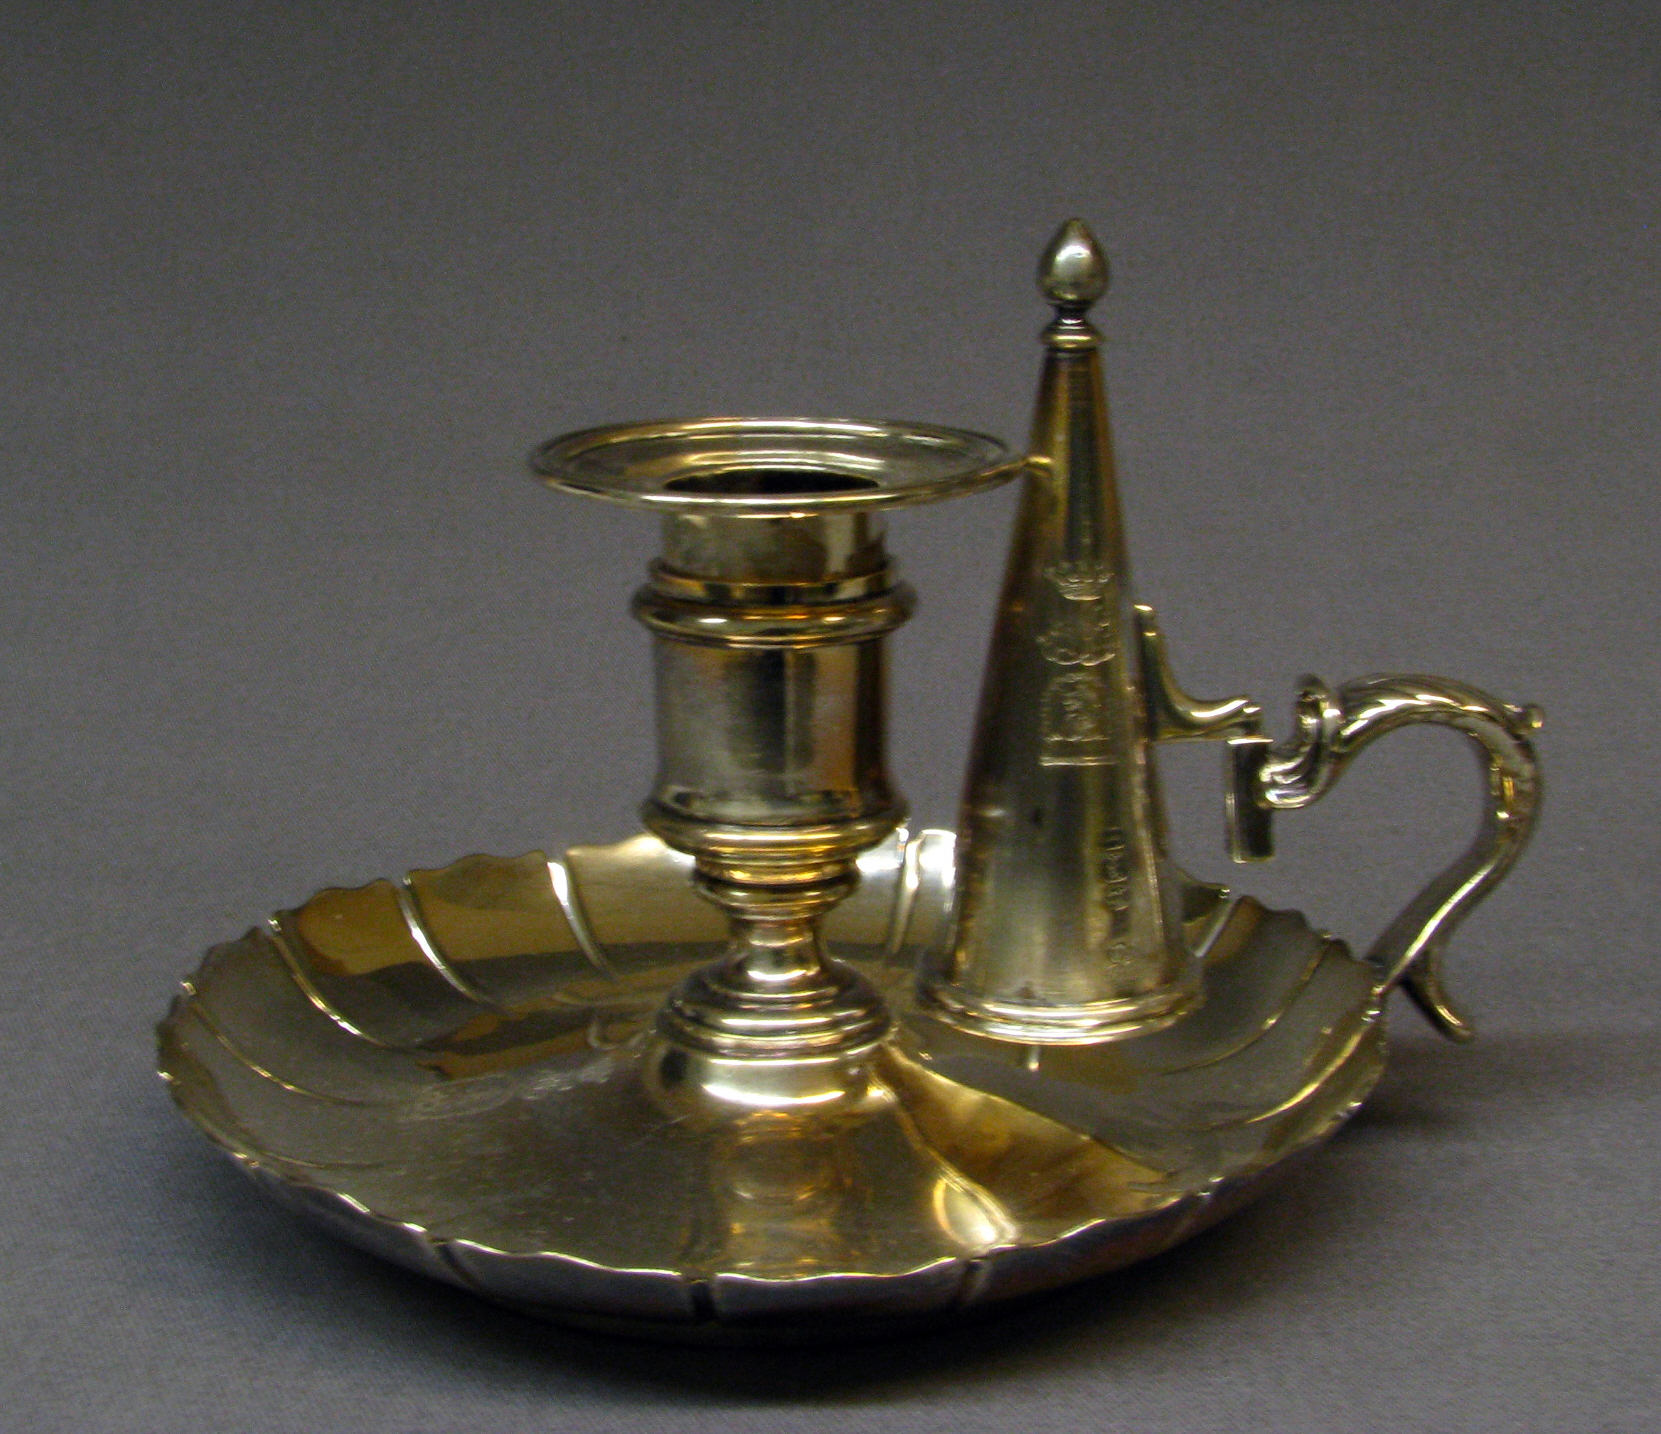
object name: chamber candlestick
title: Chamber candlestick (one of a pair)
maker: robert garrard ii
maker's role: maker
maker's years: 1818-1847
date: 1836-1837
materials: silver